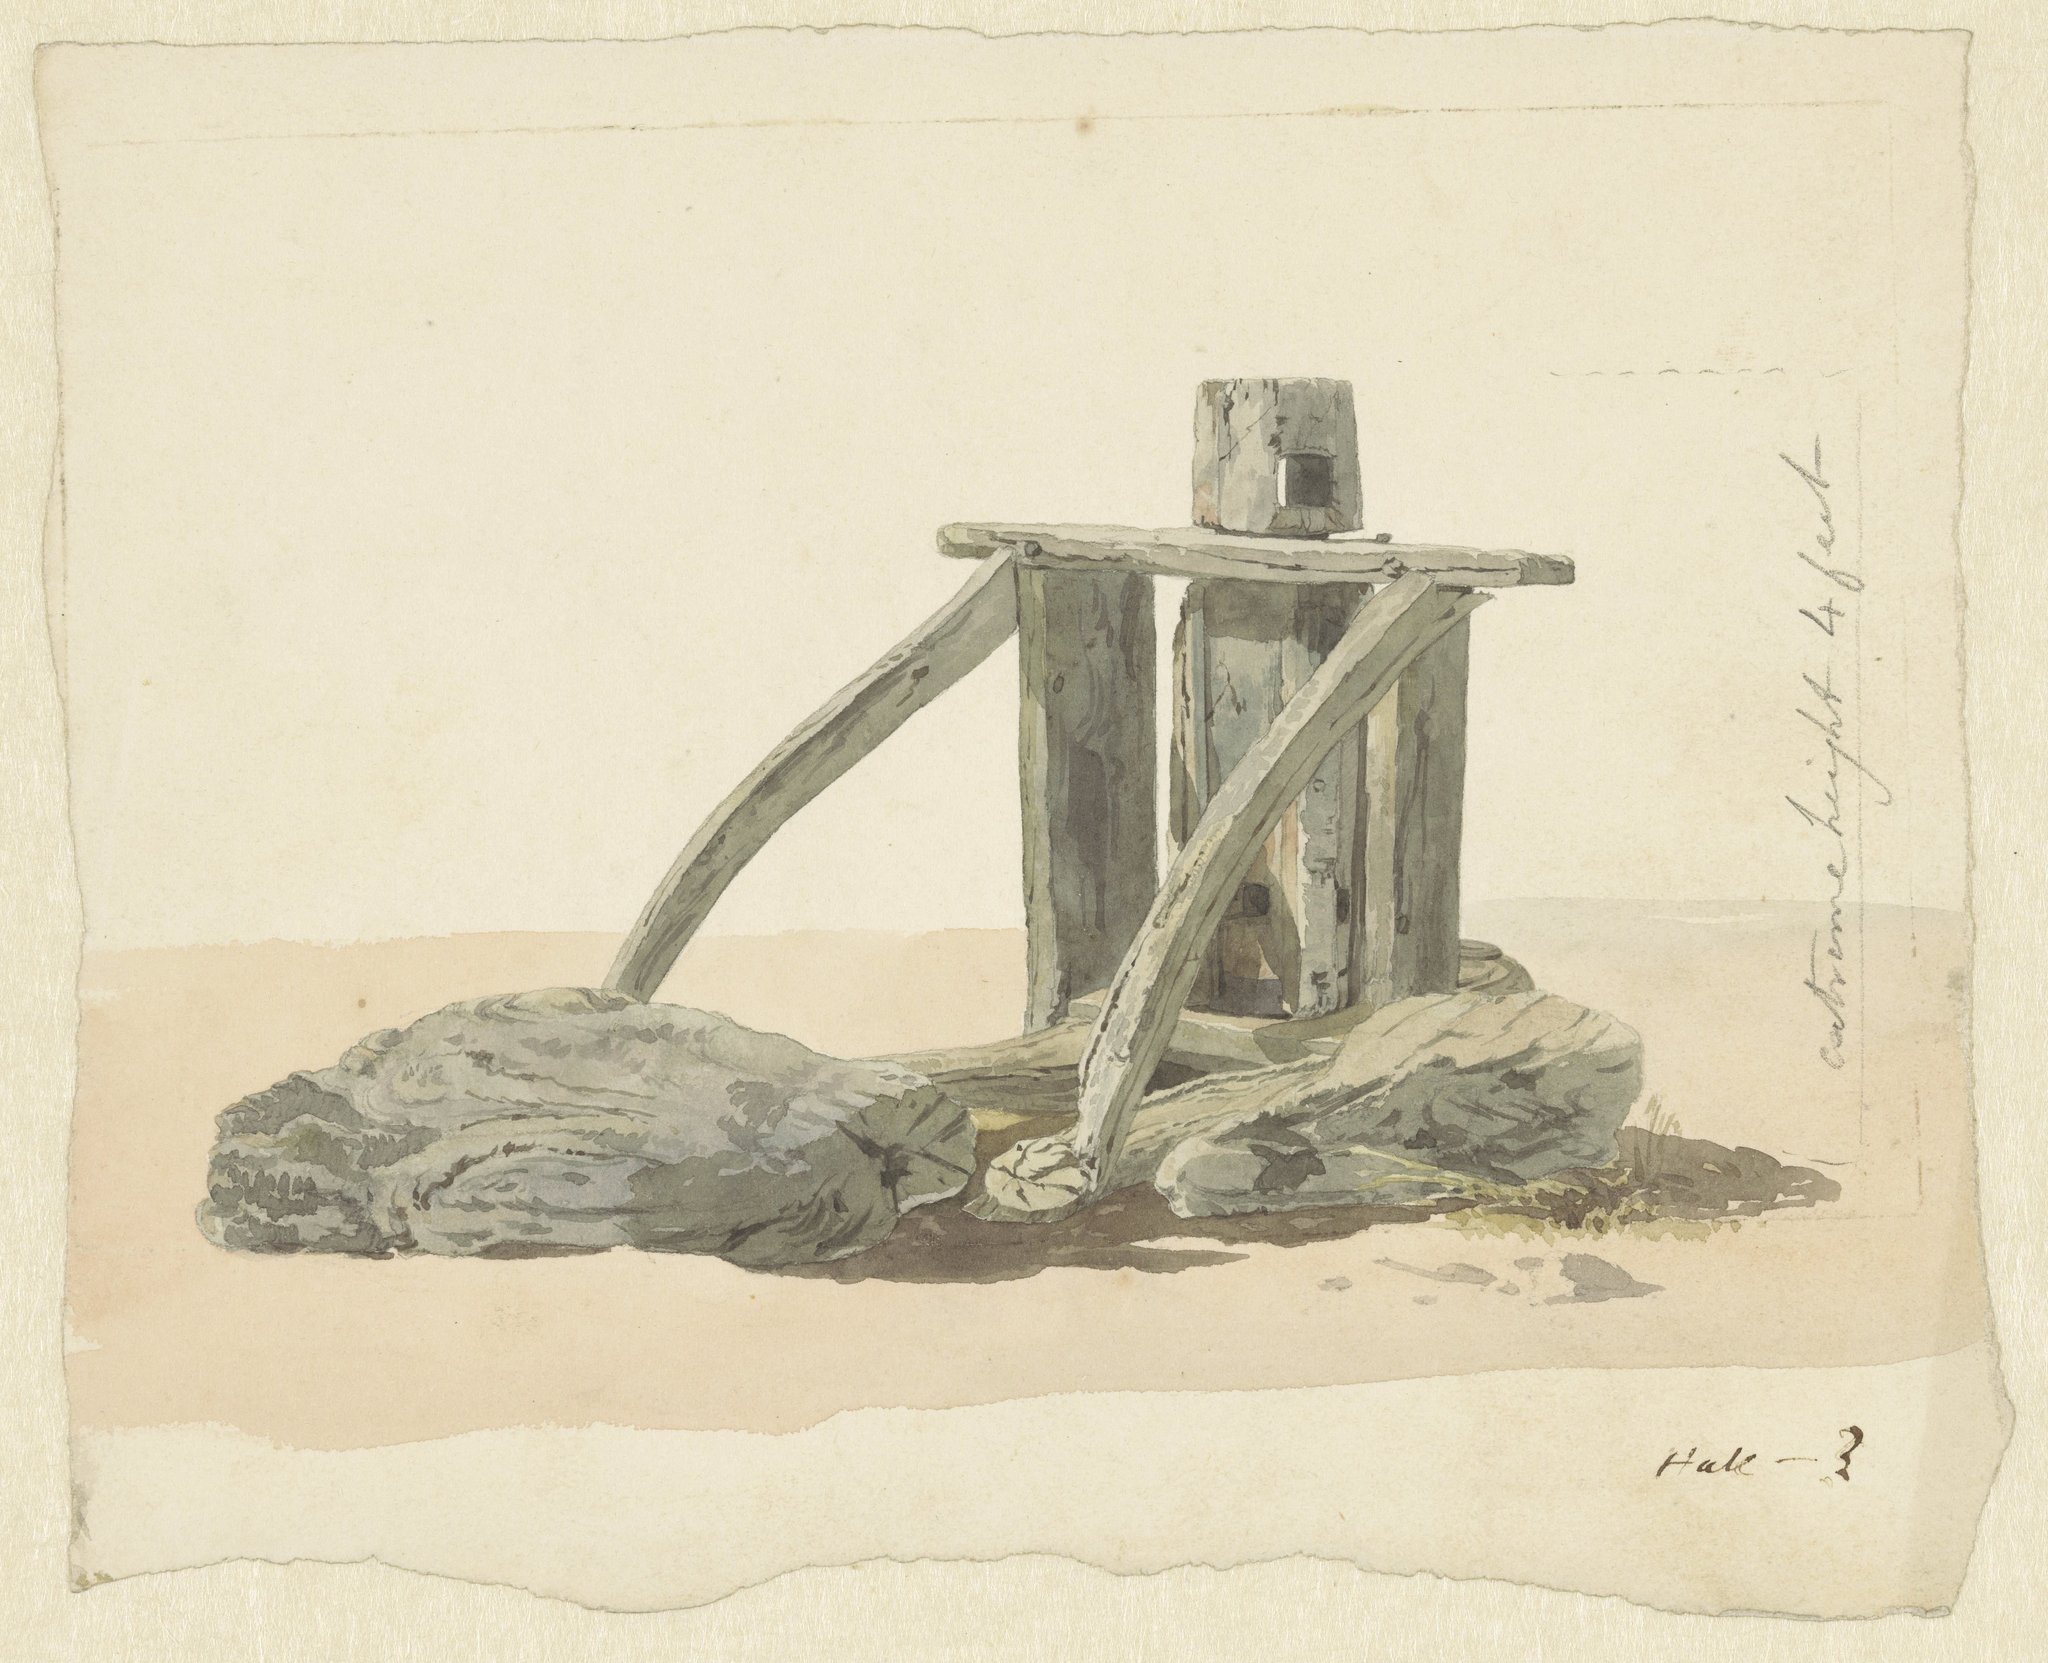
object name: drawing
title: Kaapstander op het strand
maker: john linnell (ii)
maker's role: draughtsman, print maker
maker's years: 1792-1882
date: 1802-1882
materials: paper, watercolor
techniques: brush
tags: harbour equipment